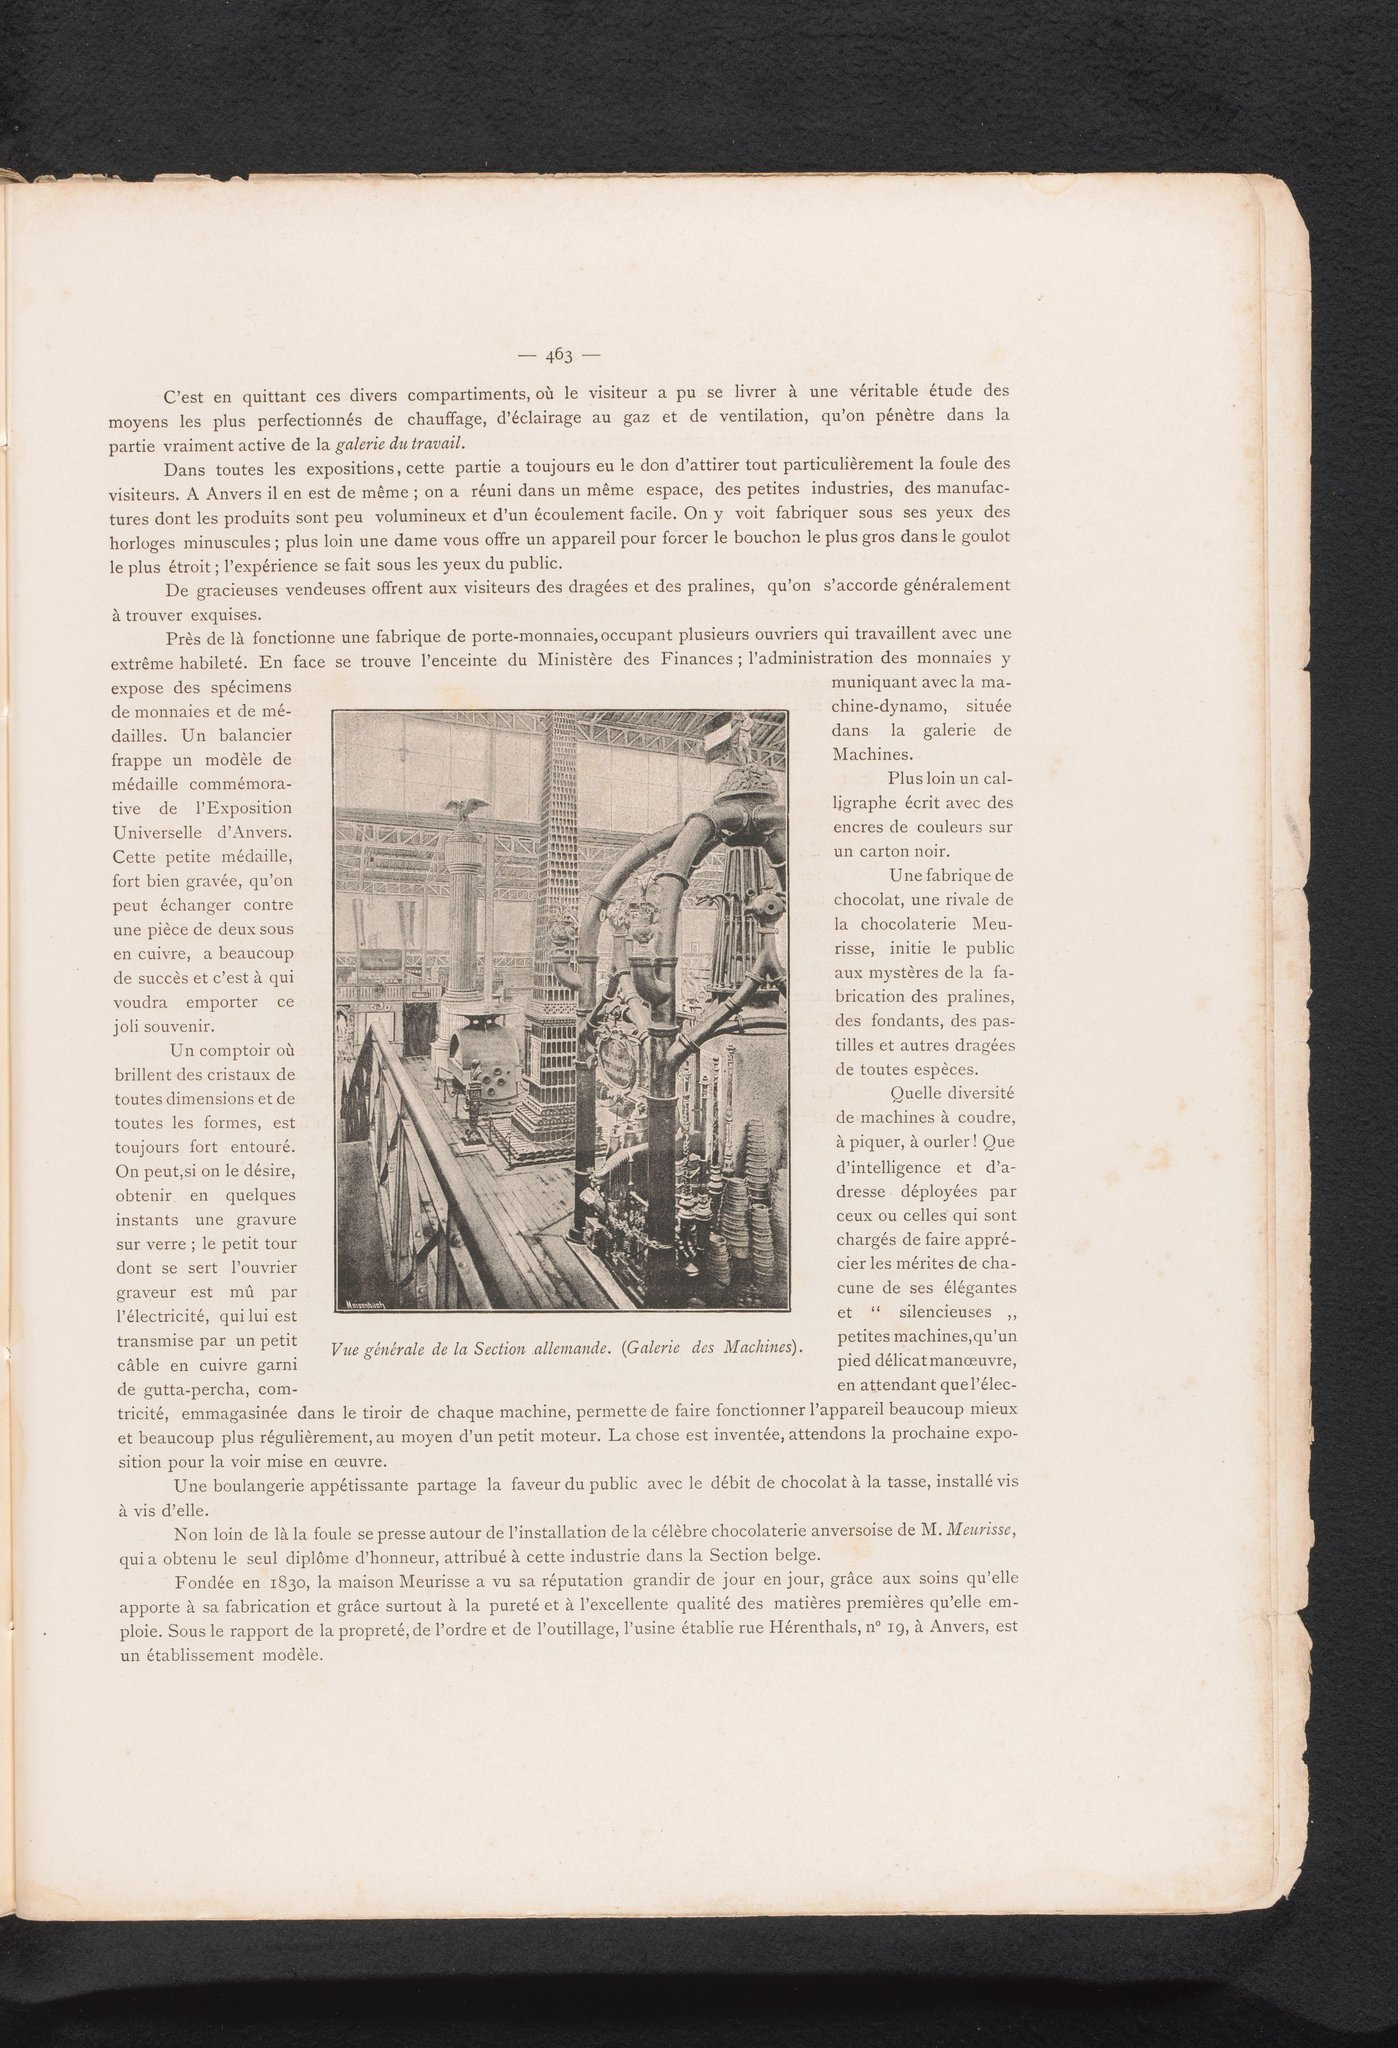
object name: photomechanical print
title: Gezicht op het Duitse deel van de Wereldtentoonstelling van 1885 in Antwerpen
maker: Anonymous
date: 1880-1885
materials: paper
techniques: autotype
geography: antwerp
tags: world fair, world exhibition, antwerp